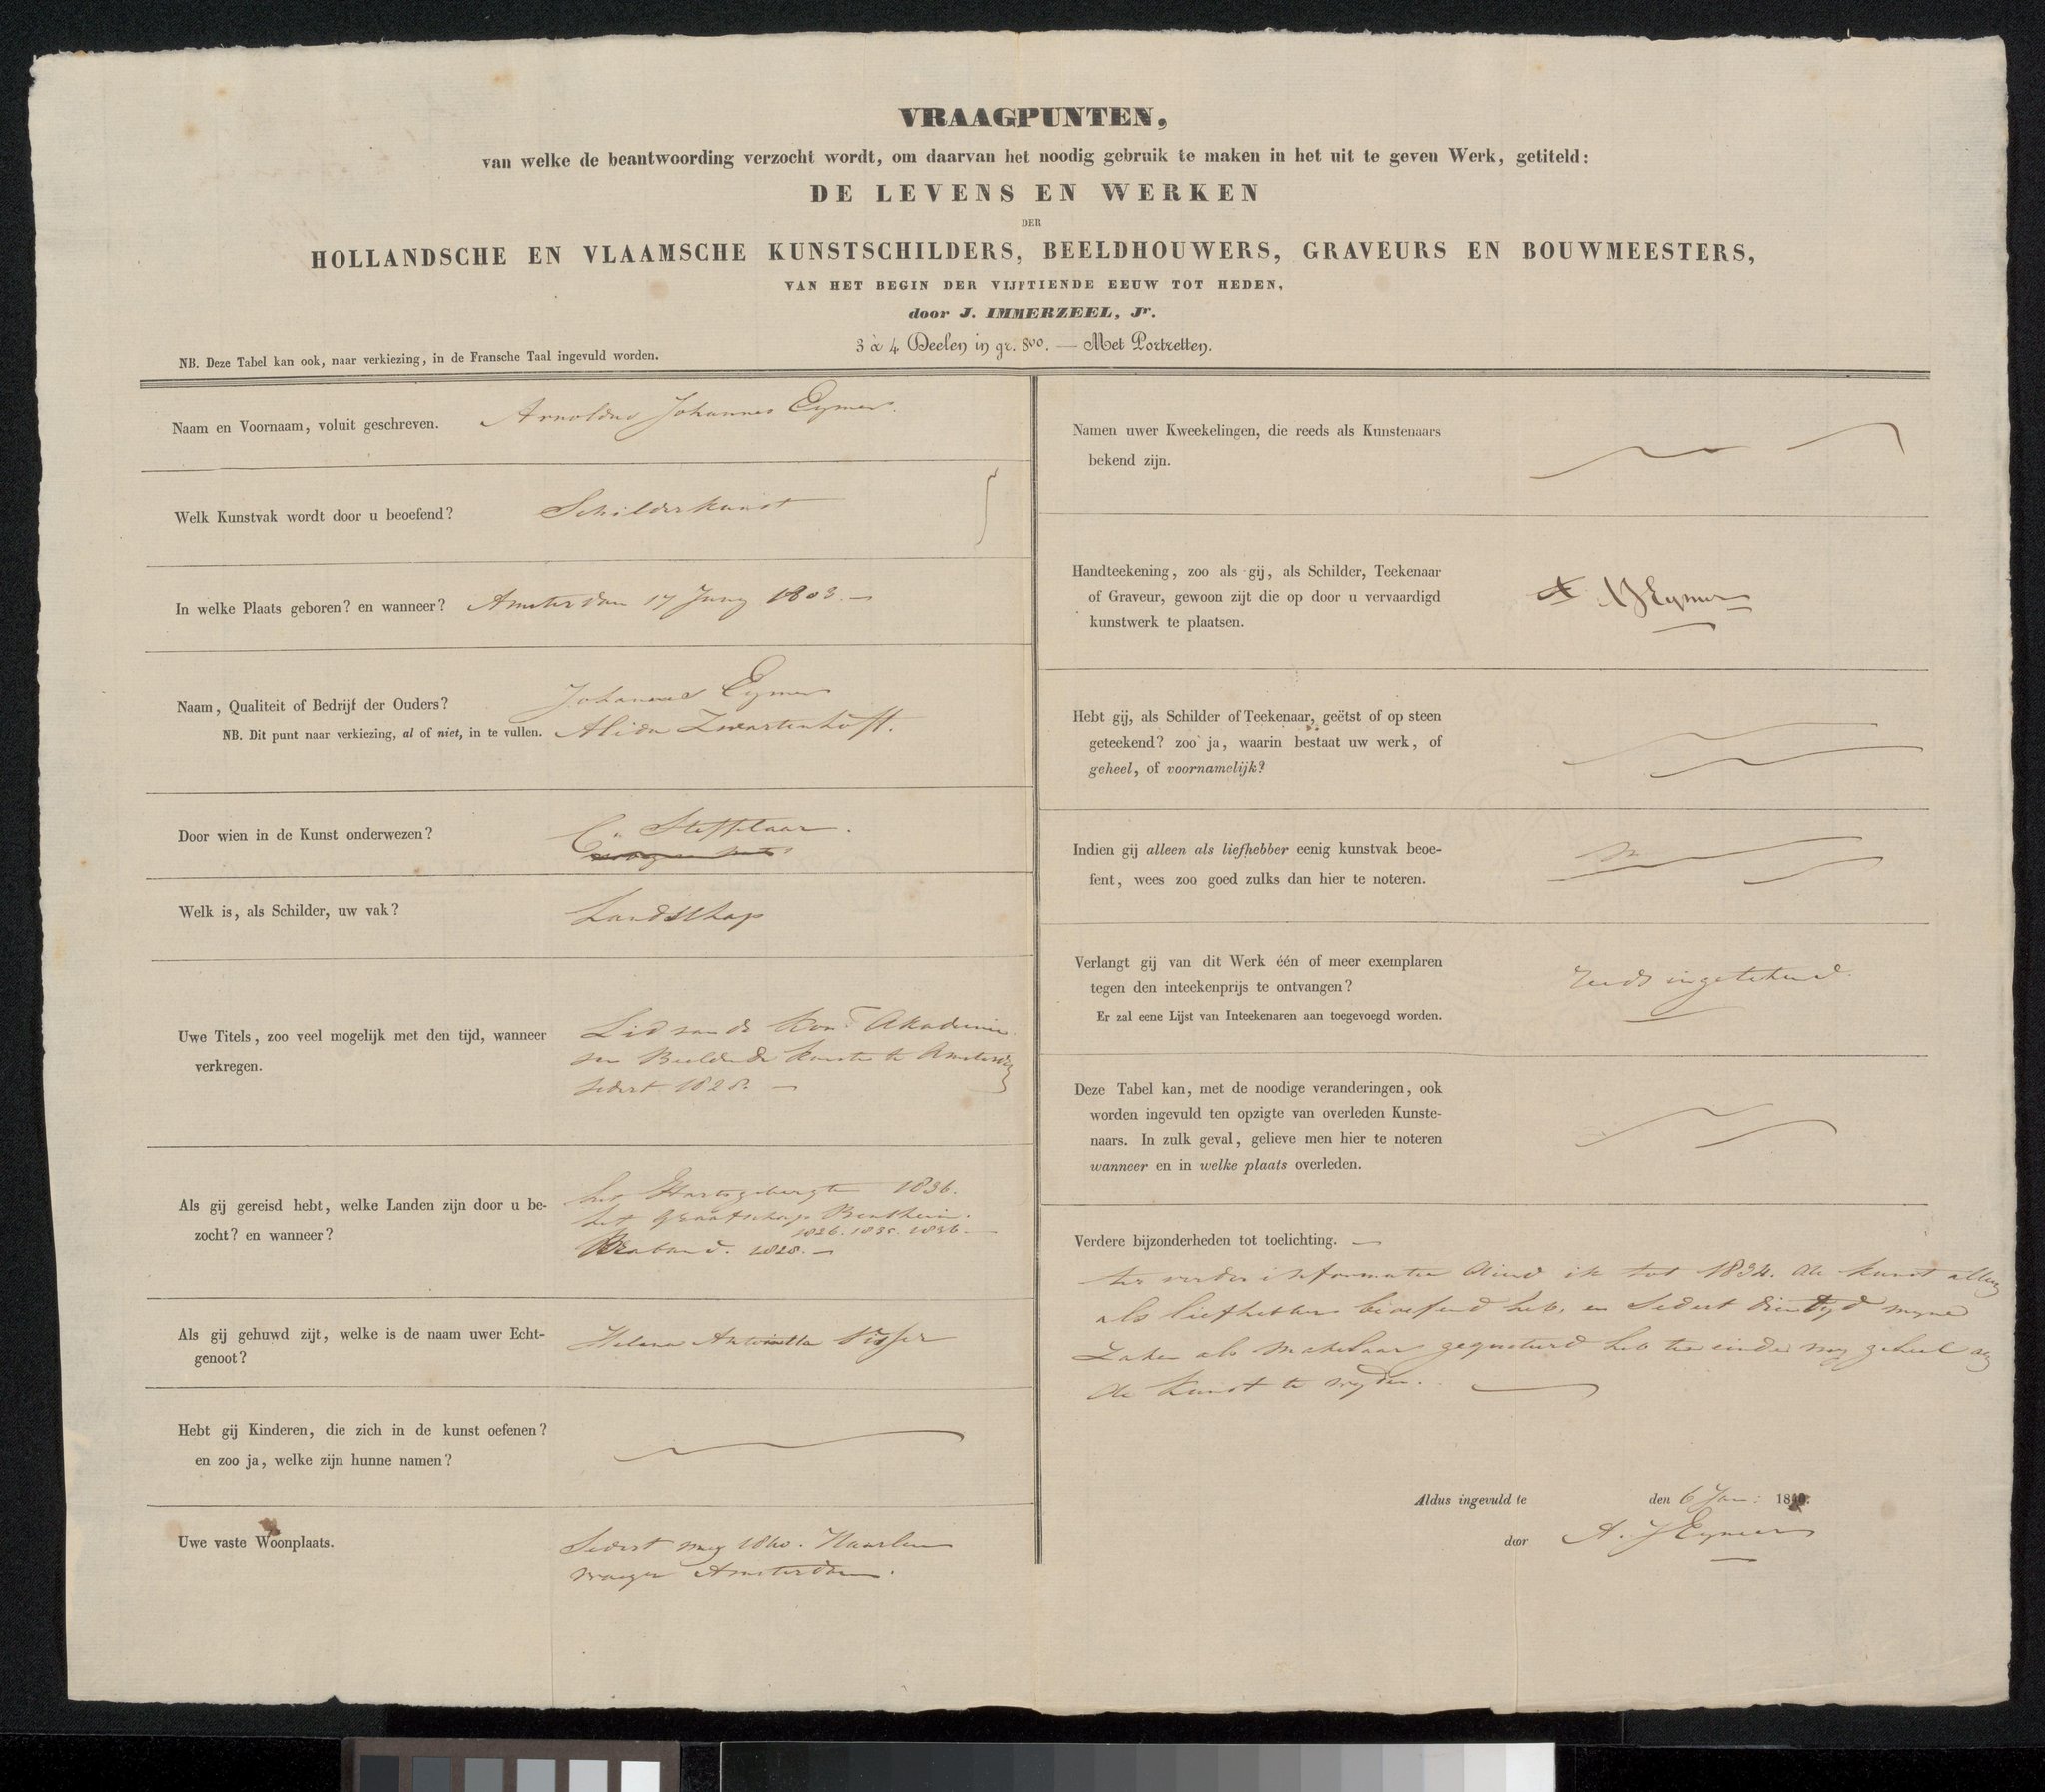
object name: manuscript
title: Enquêteformulier ingevuld door Arnoldus Johannes Eymer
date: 1840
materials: ink, paper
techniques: pen, printing, writing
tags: arnoldus johannes eymer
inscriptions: watermark, inscription: ‘Vraagpunten,/ van welke de beantwoording verzocht wordt, om daarvan het noodig gebruik te maken in het uit te geven Werk, getiteld: De levens en werken/ der Hollandsche en Vlaamsche kunstschilders, beeldhouwers,/ graveurs en bouwmeesters, van het begin der vijftiende eeuw tot heden/ door J. Immerzeel, Jr.’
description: Opgenomen in: Immerzeel, J. Jr., De levens en werken der Hollandsche en Vlaamsche kunstschilders, beeldhouwers, graveurs en bouwmeesters, van het begin der vijftiende eeuw tot heden, Amsterdam: J.C. van Kesteren, 1842-1843.